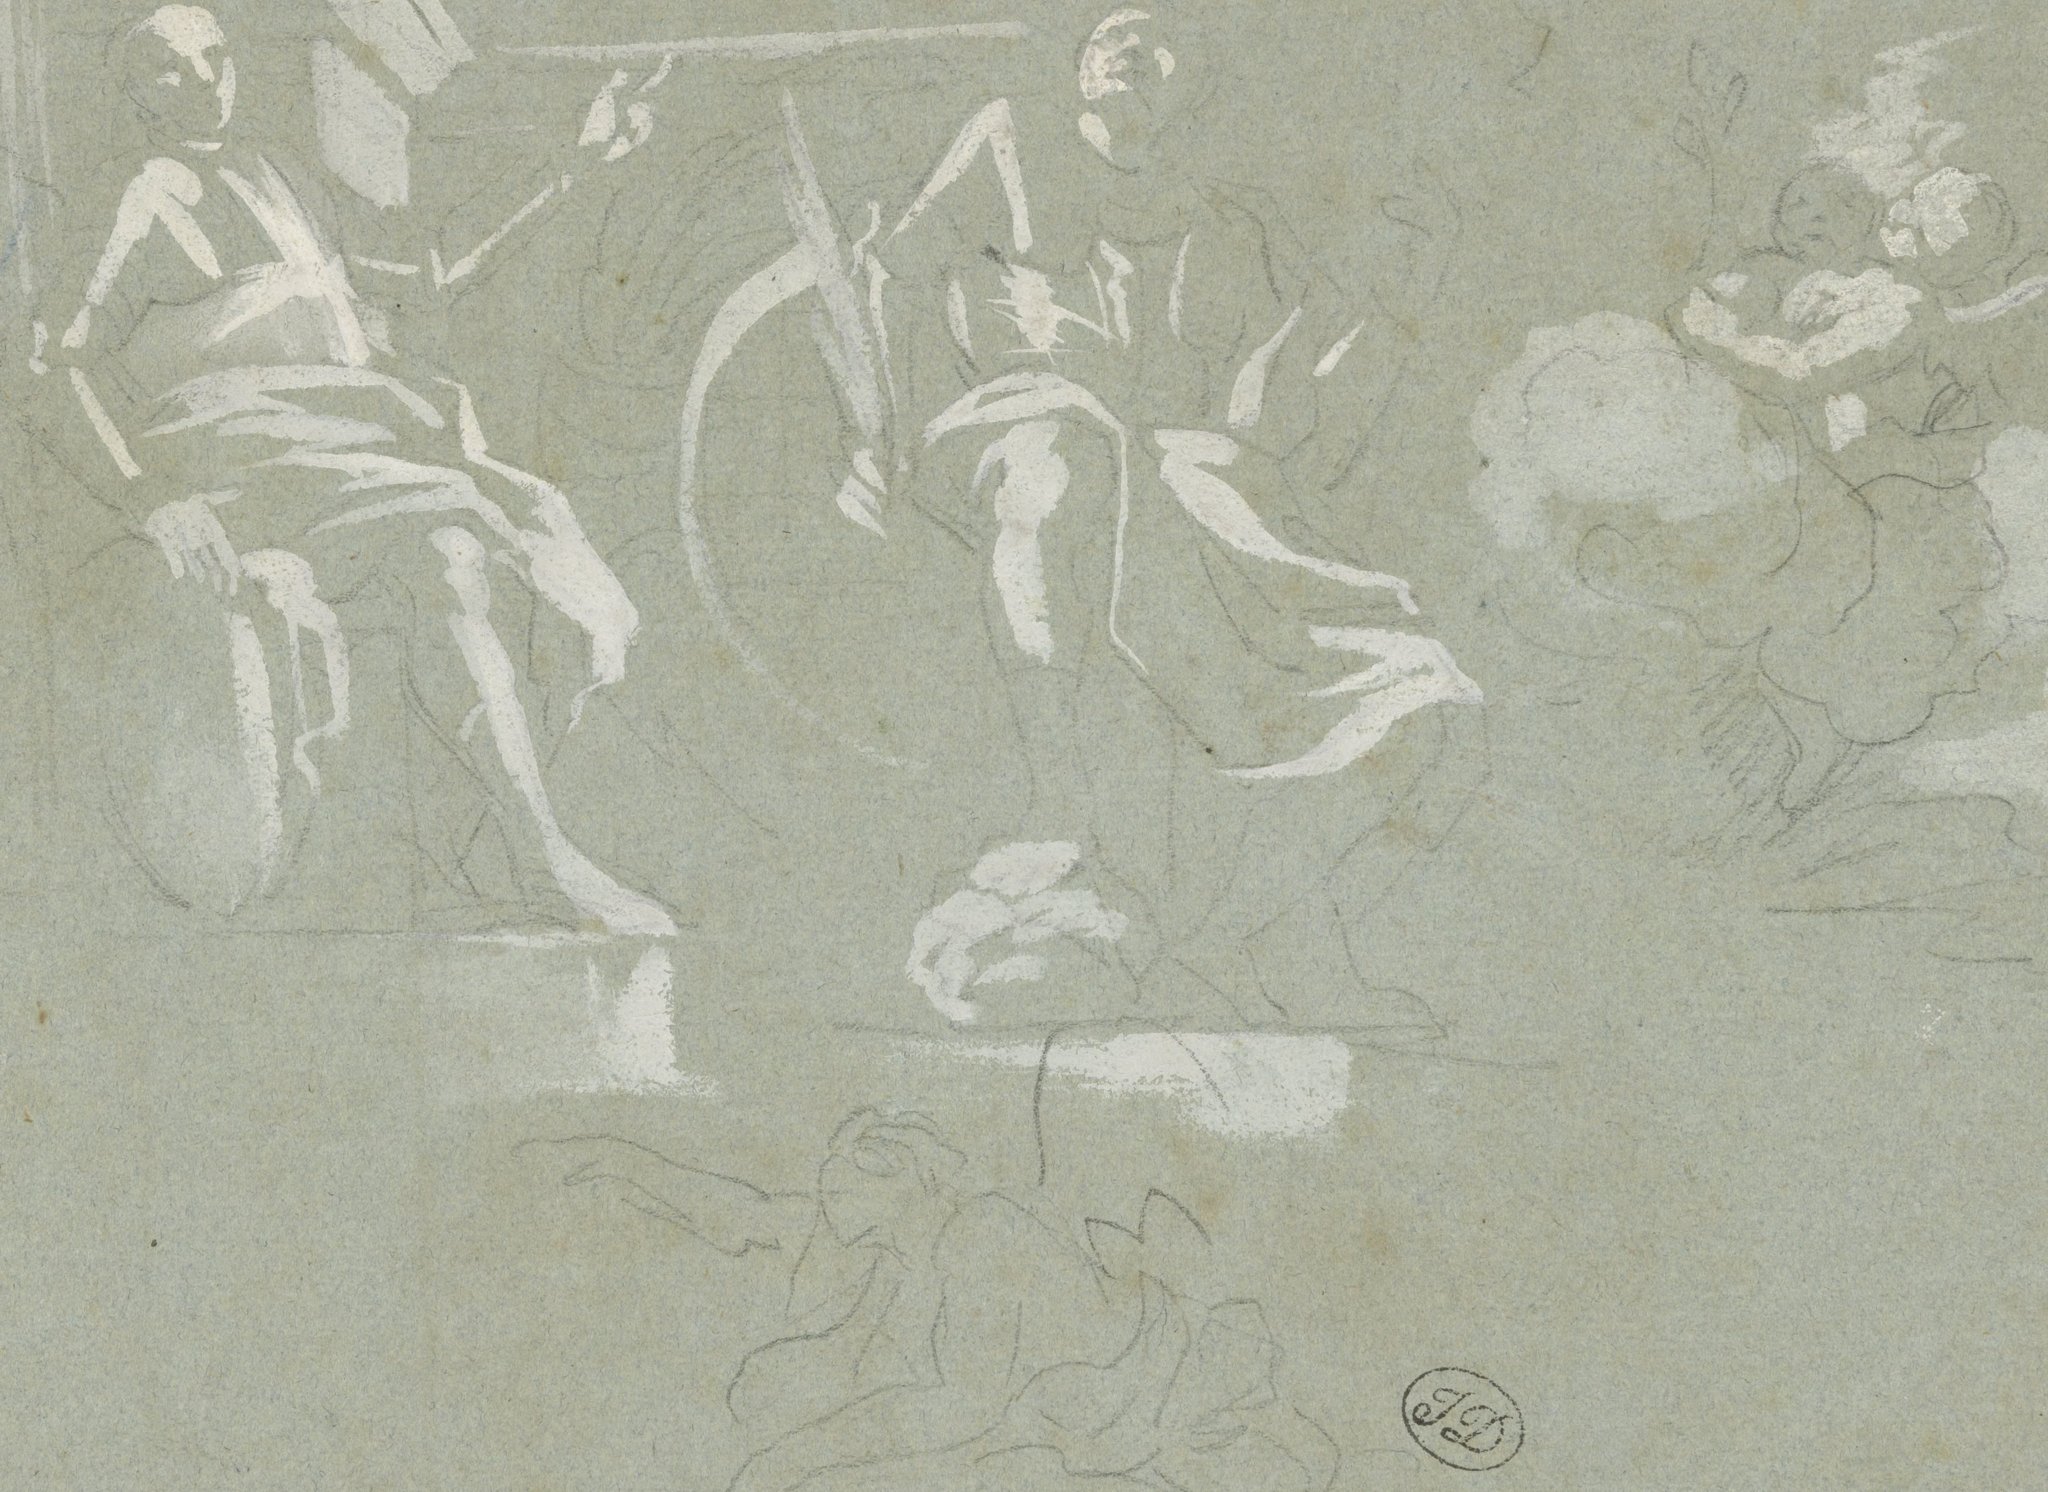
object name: drawing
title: Twee zittende figuren en engelen op wolken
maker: mattia preti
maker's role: draughtsman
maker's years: 1613-1699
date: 1661-1666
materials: chalk, paint, paper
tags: sitting figure, lower angel(s), male saints (with name)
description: Twee zittende figuren (de heilige Nicasius van Reims) en engelen op wolken.